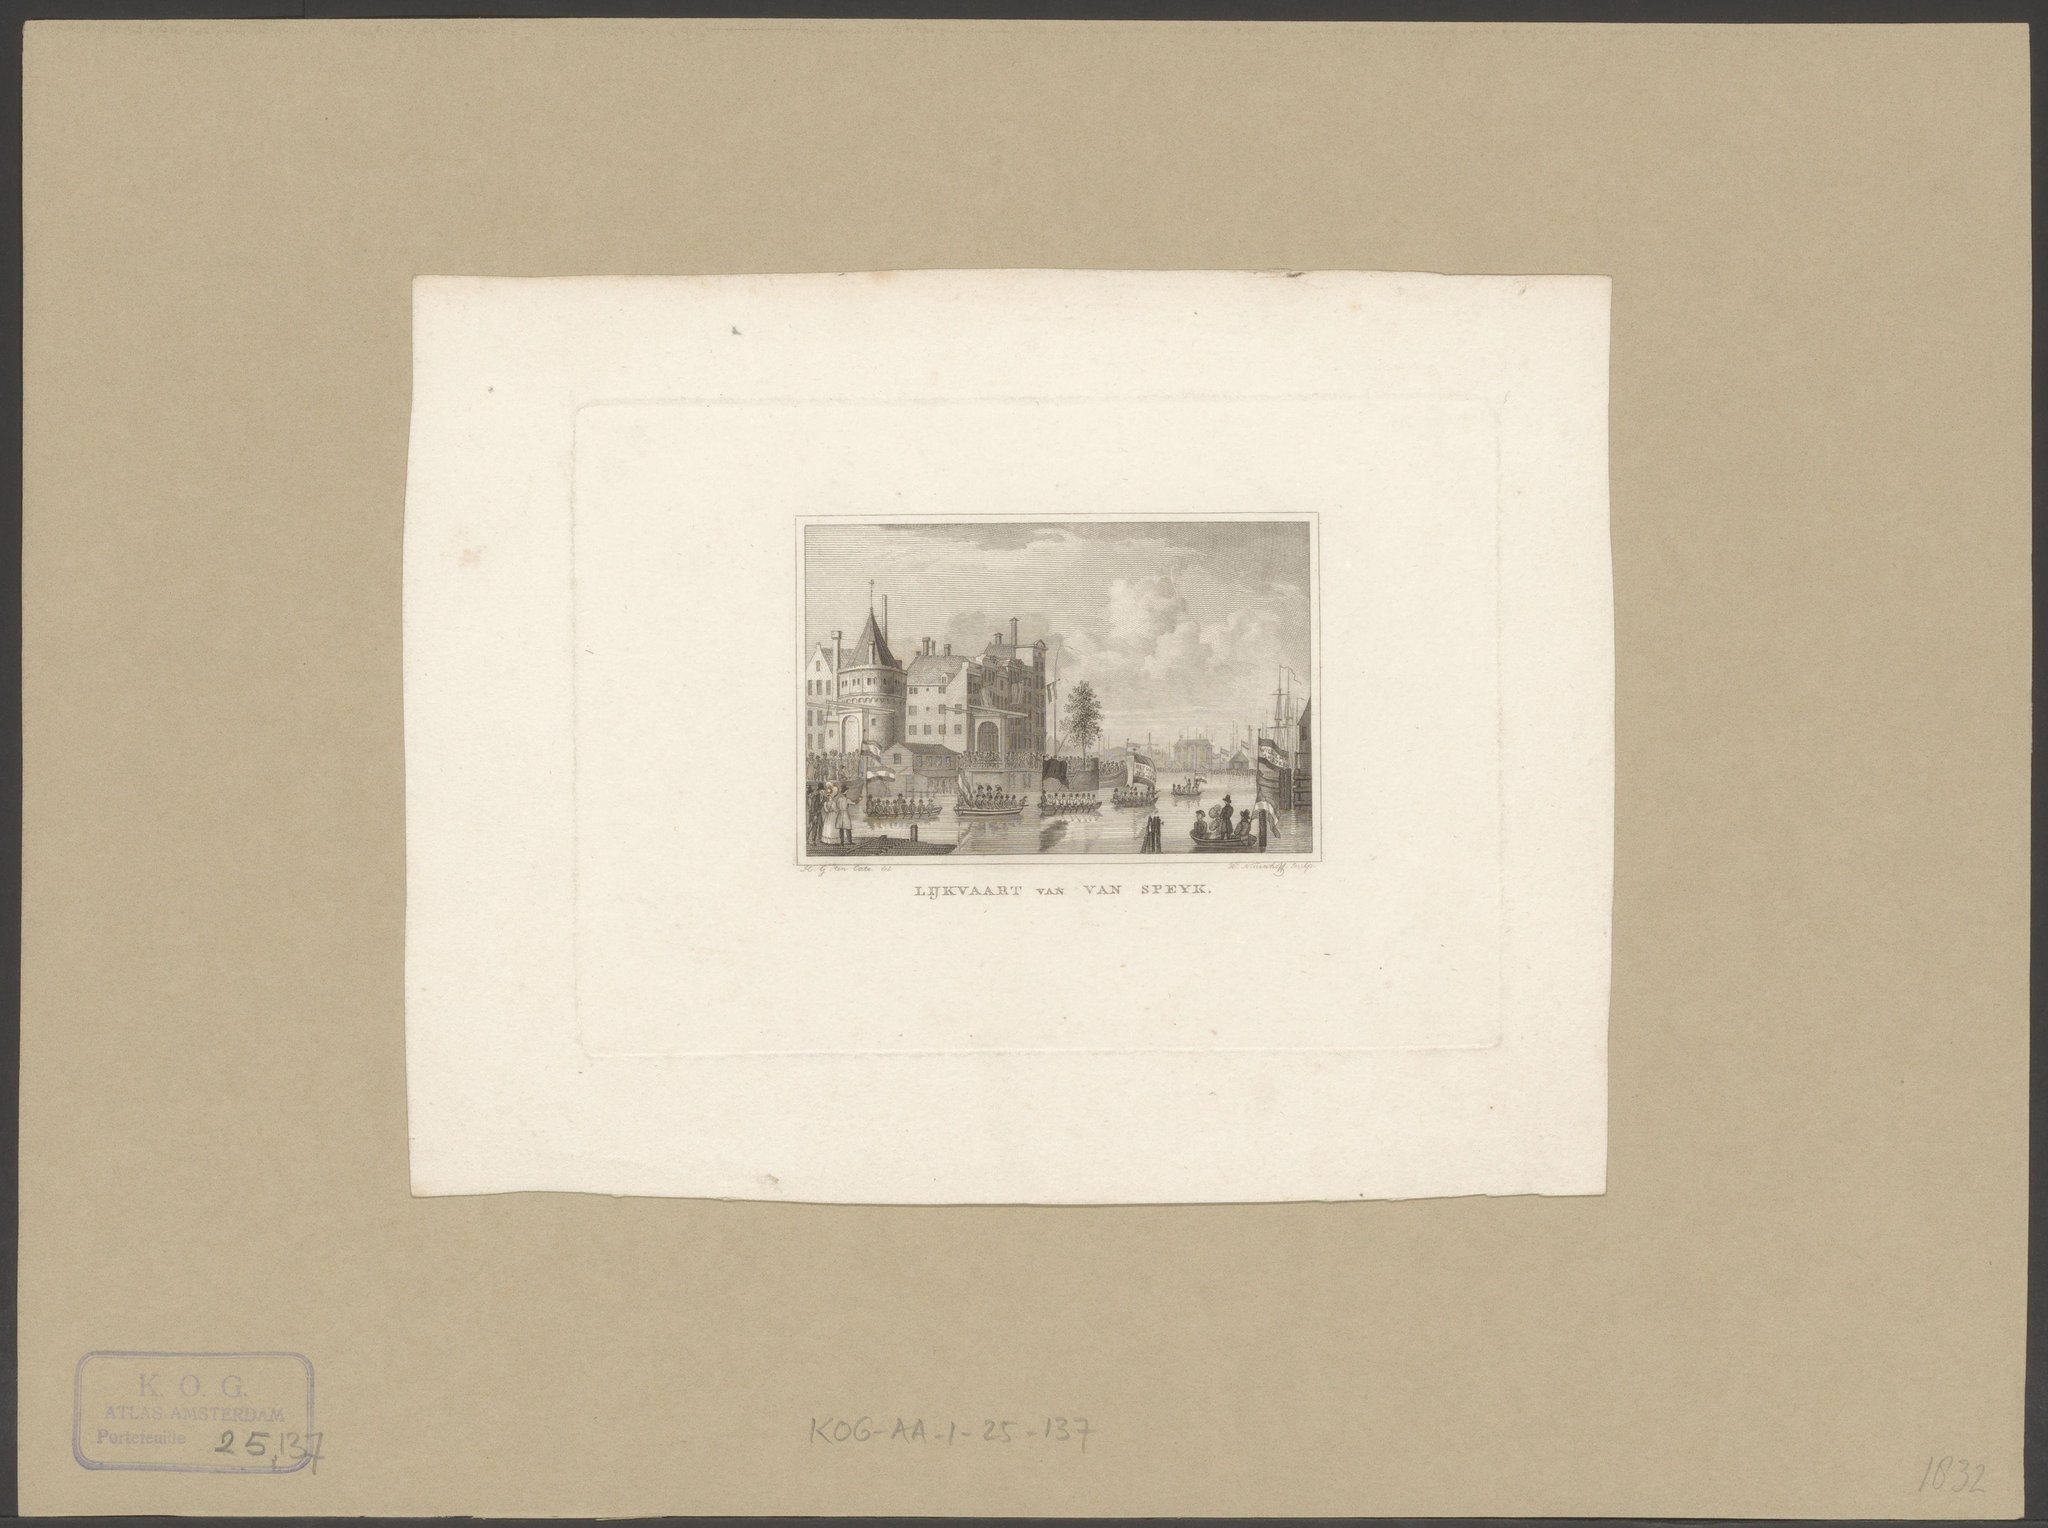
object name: print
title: Lijkvaart van Van Speyk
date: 1833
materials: paper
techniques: engraving, etching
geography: amsterdam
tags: public funeral - aa - festivities on the water, cortege, funeral procession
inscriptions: collector's mark: ‘25.137’ Lugt 1641b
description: Prent gebruikt in: Nederlandsche Volks-Almanak (1833). Amsterdam: Hendrik Frijlink, 1833. De lijkvaart van kanonneerbootcommandant Carel Josephus van Speijk op 4 mei 1832 in Amsterdam. Op het water varen vier sloepen uit de lijkstoet van Van Speijk. Links de Schreierstoren.